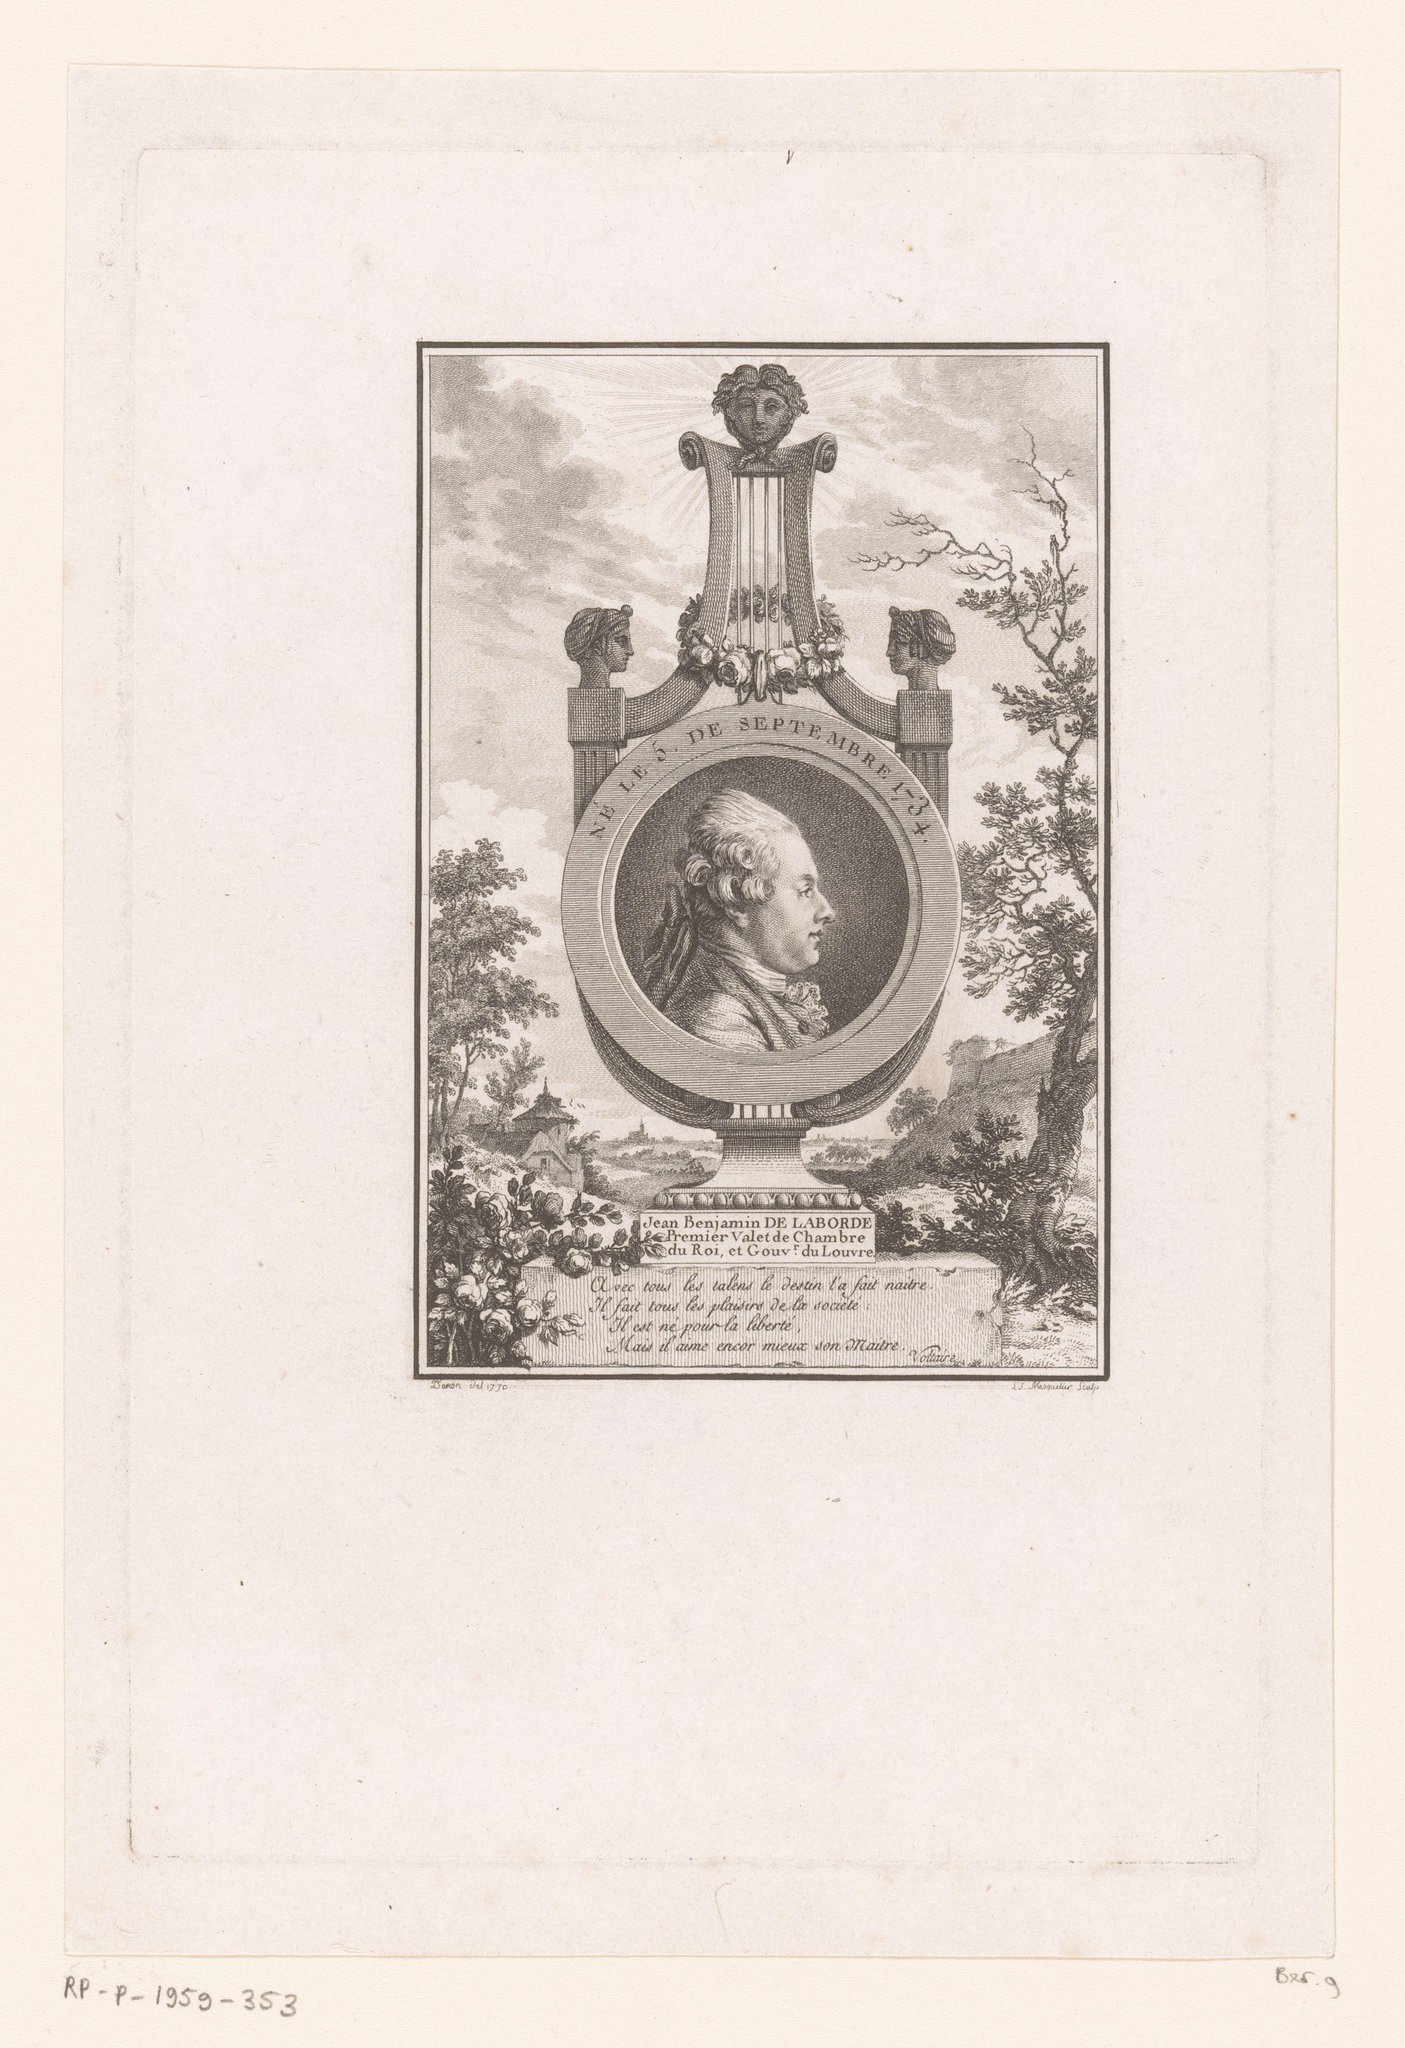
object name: print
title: Landschap met het portret van Jean-Benjamin de La Borde in een medaillon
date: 1774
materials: paper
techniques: engraving, etching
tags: paris, historical persons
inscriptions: inscription: ‘1/45’, collector's mark: Lugt 2228, collector's mark: Lugt 2760, number: ‘773’